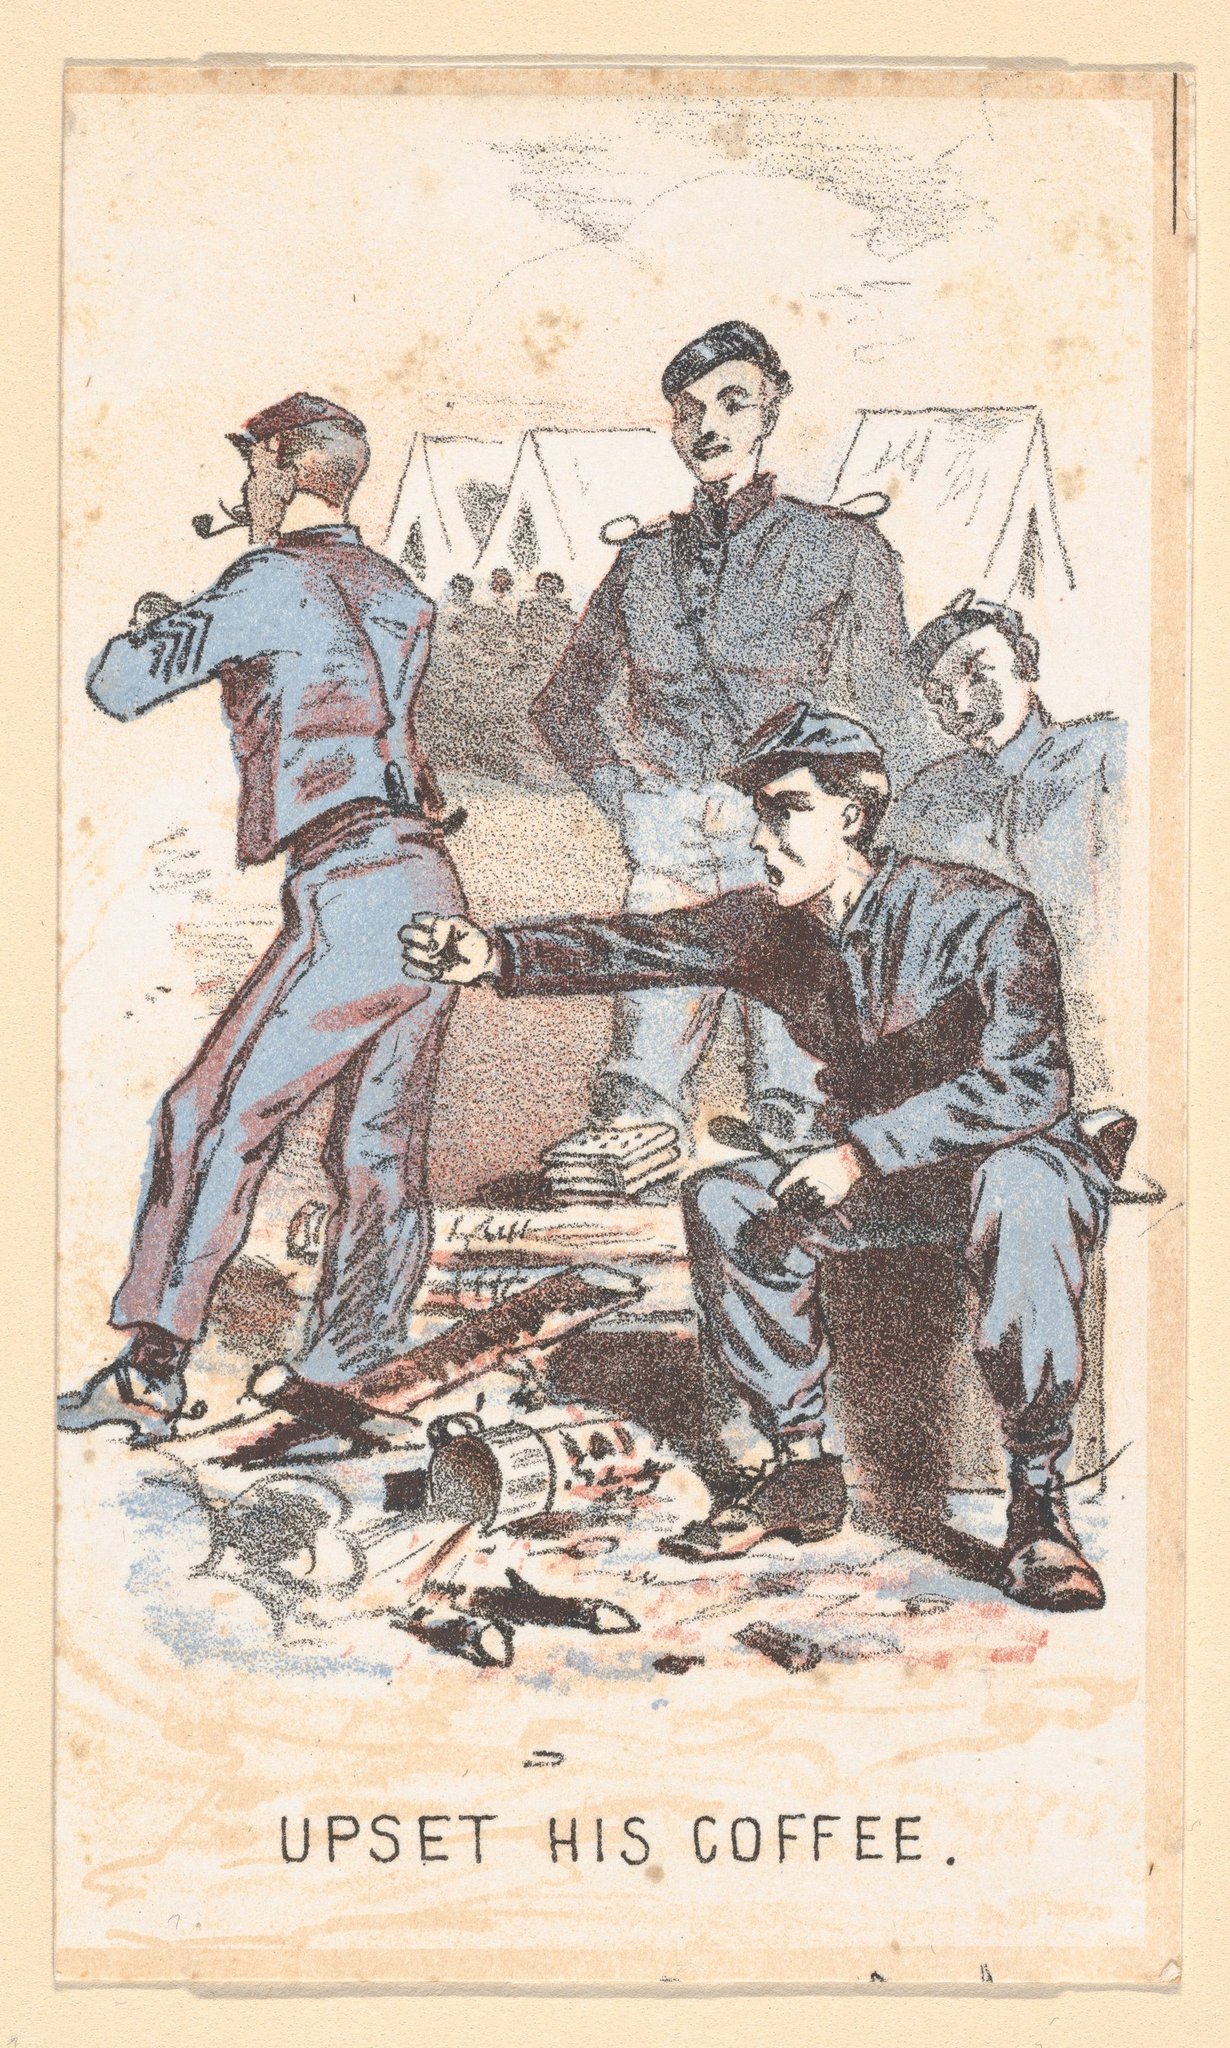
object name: print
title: Life in Camp, Part 1: Upset His Coffee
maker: winslow homer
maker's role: artist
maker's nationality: american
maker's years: 1836-1910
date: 1864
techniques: lithograph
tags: soldiers,american civil war,men